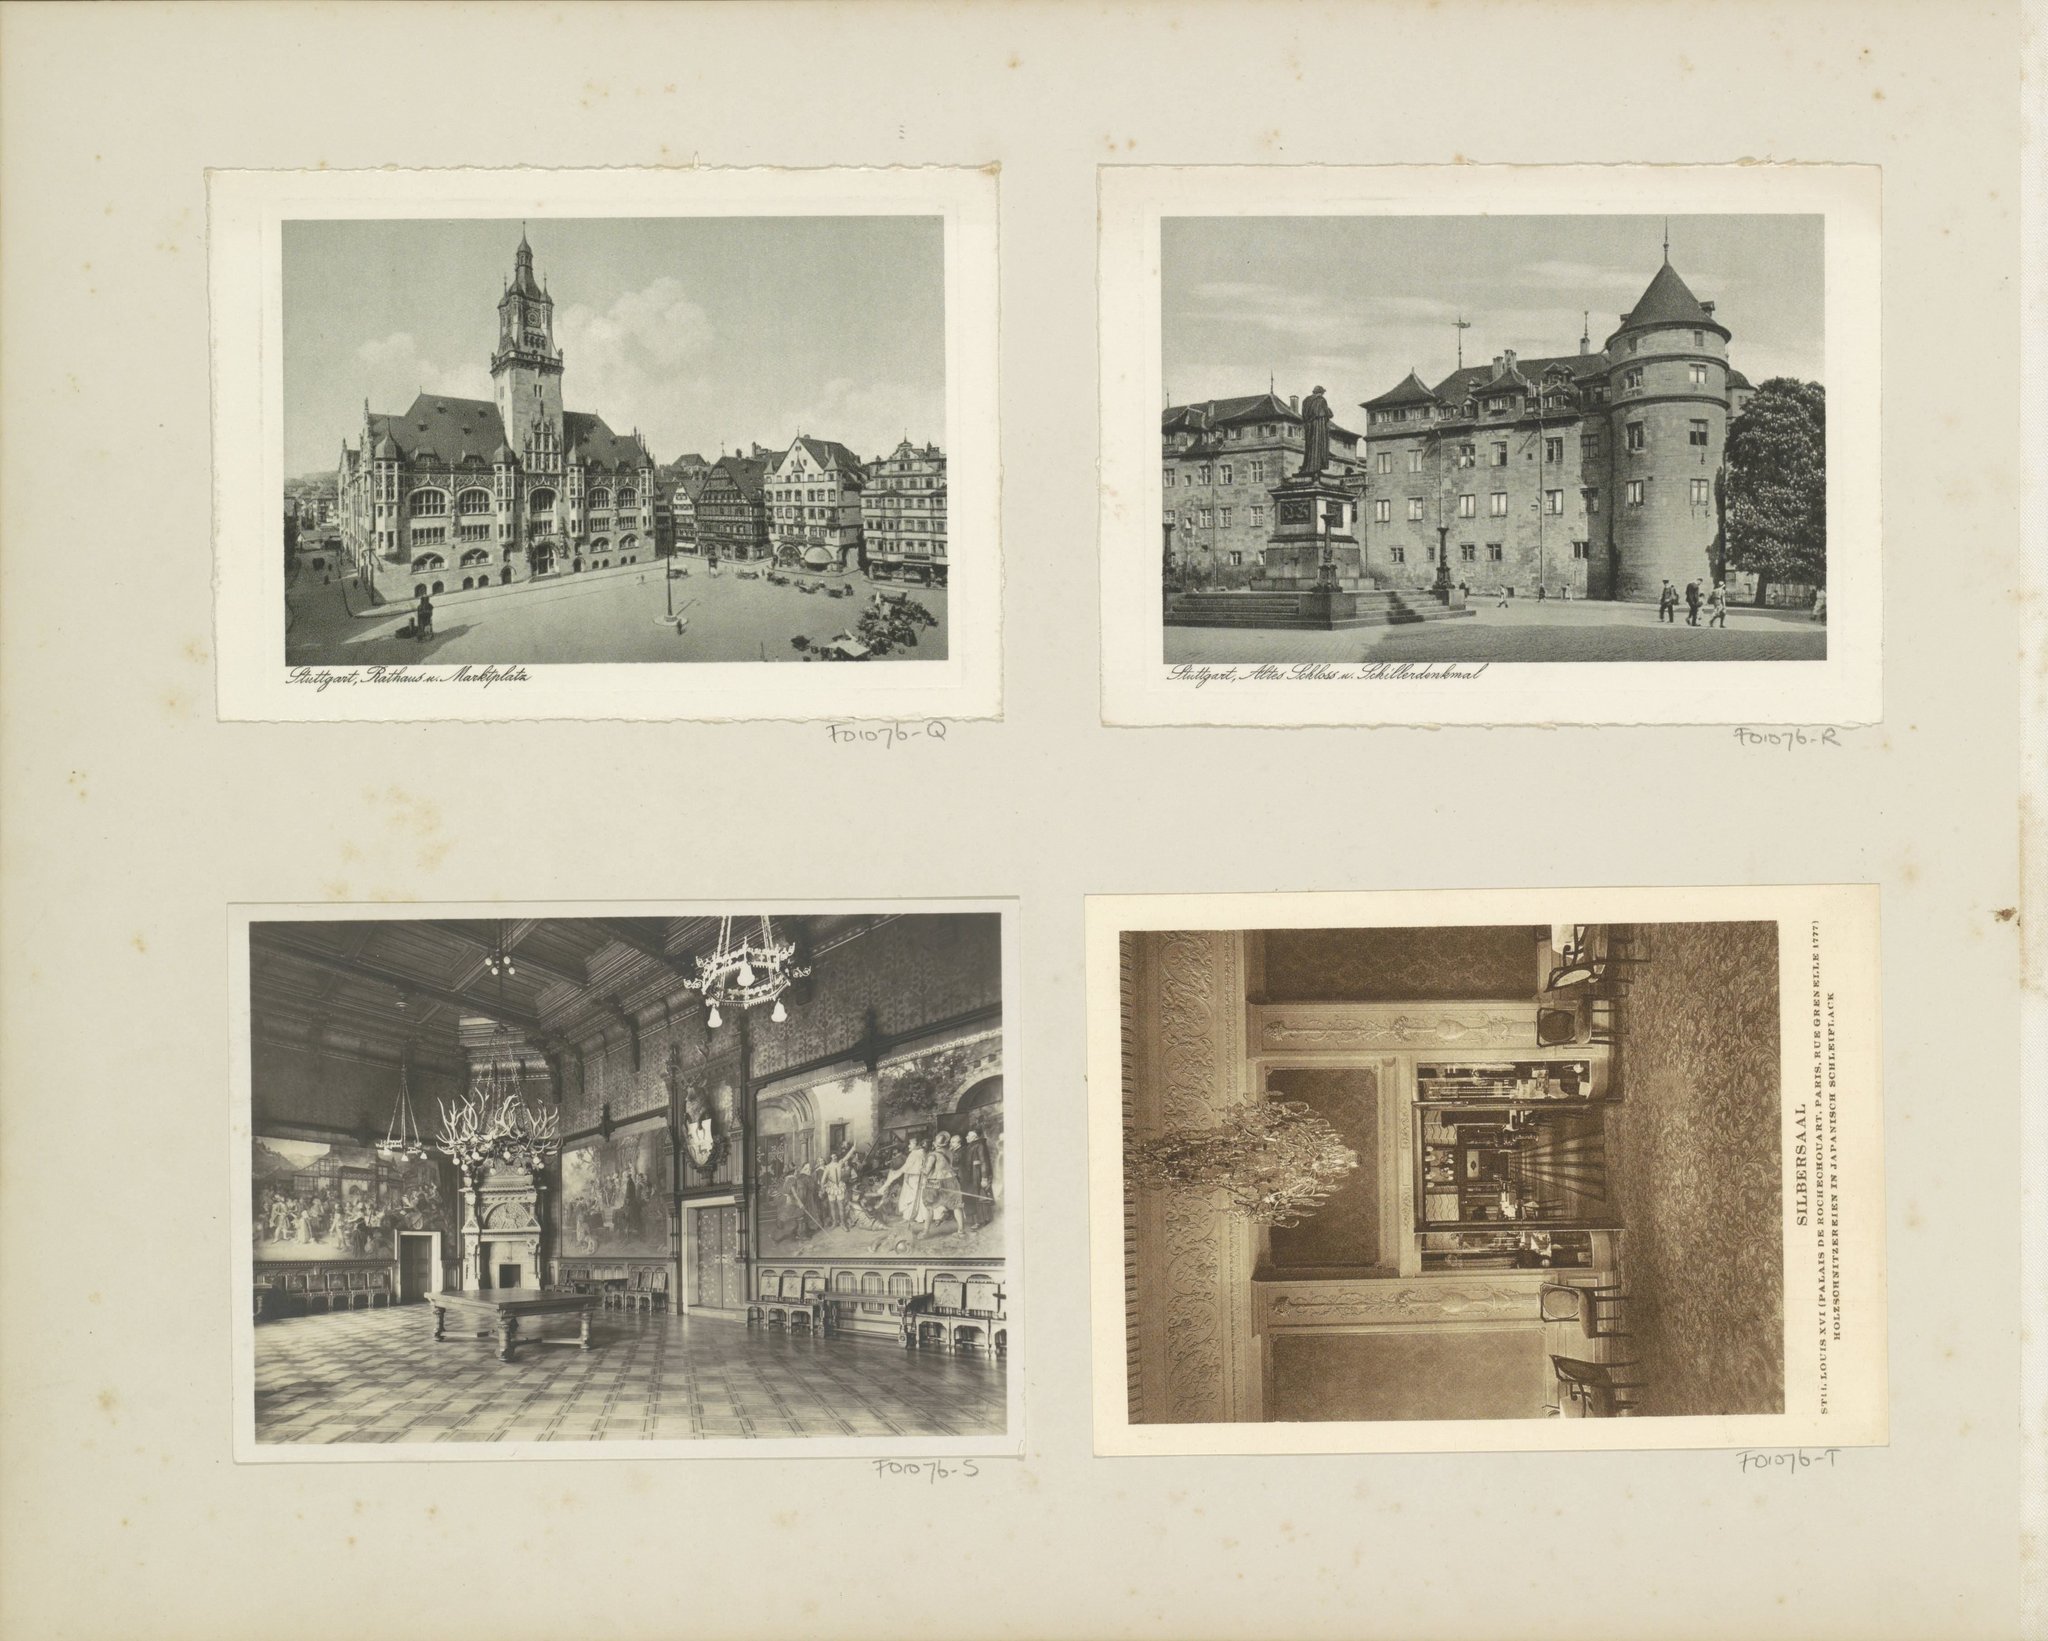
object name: photograph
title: Silbersaal stil Louis XVI (Palais de Rochechouart Paris Rue Genelle 1777)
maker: Anonymous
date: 1900-1940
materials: cardboard, paper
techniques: rotogravure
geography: paris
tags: interior of the house, paris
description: Onderdeel van Album met foto's van spoorwegen in Nederlands-Indië en prentbriefkaarten.